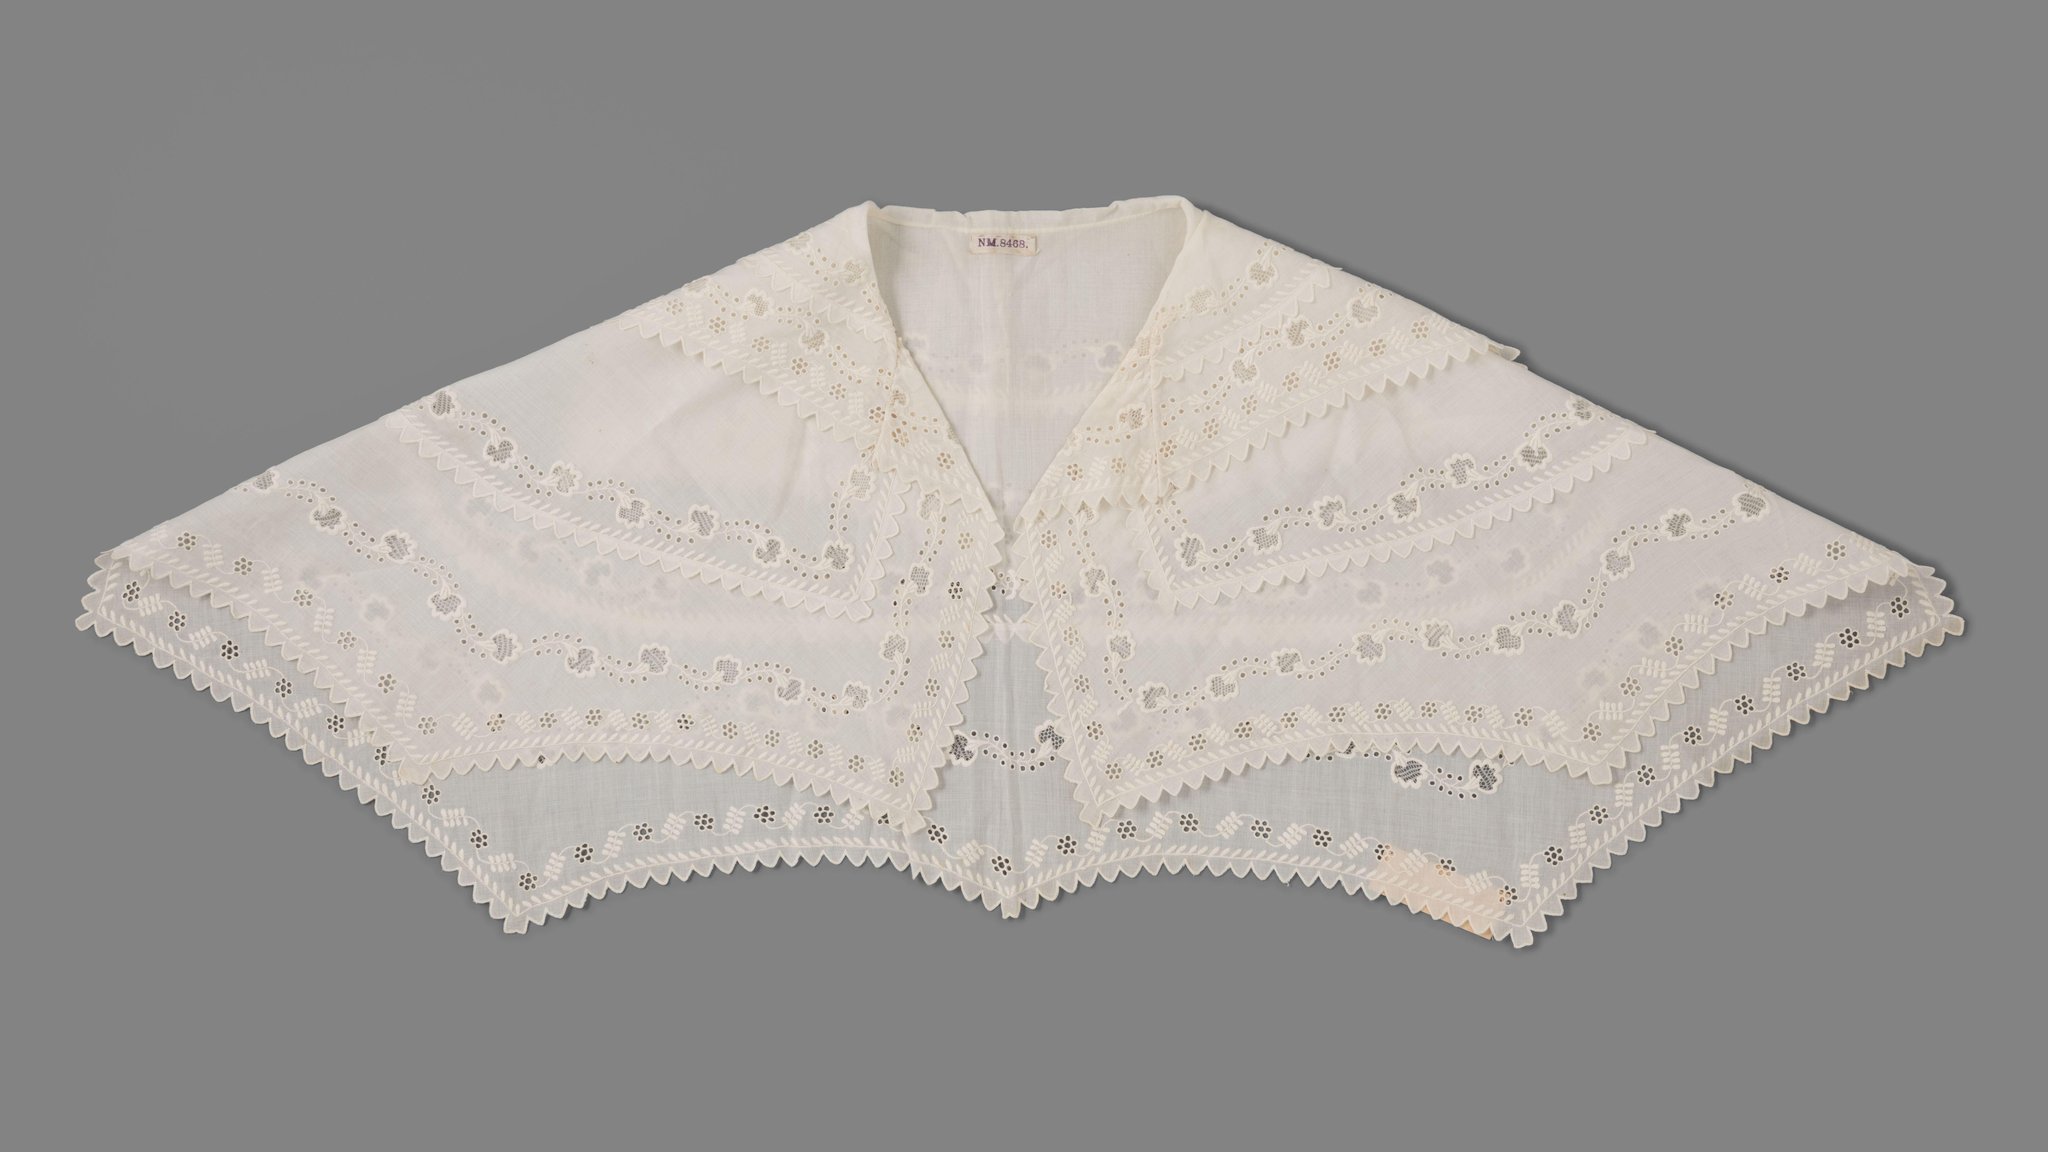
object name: womenswear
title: Kraag van batist met overslag en gefestonneerde getande randen, ajour geborduurd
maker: Anonymous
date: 1850-1888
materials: linen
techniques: lace, embroidery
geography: western europe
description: Kraag van batist met overslag en gefestonneerde getande randen, ajour geborduurd. Langs de getande randen is de kraag gedecoreerd met meanderende florale motieven.